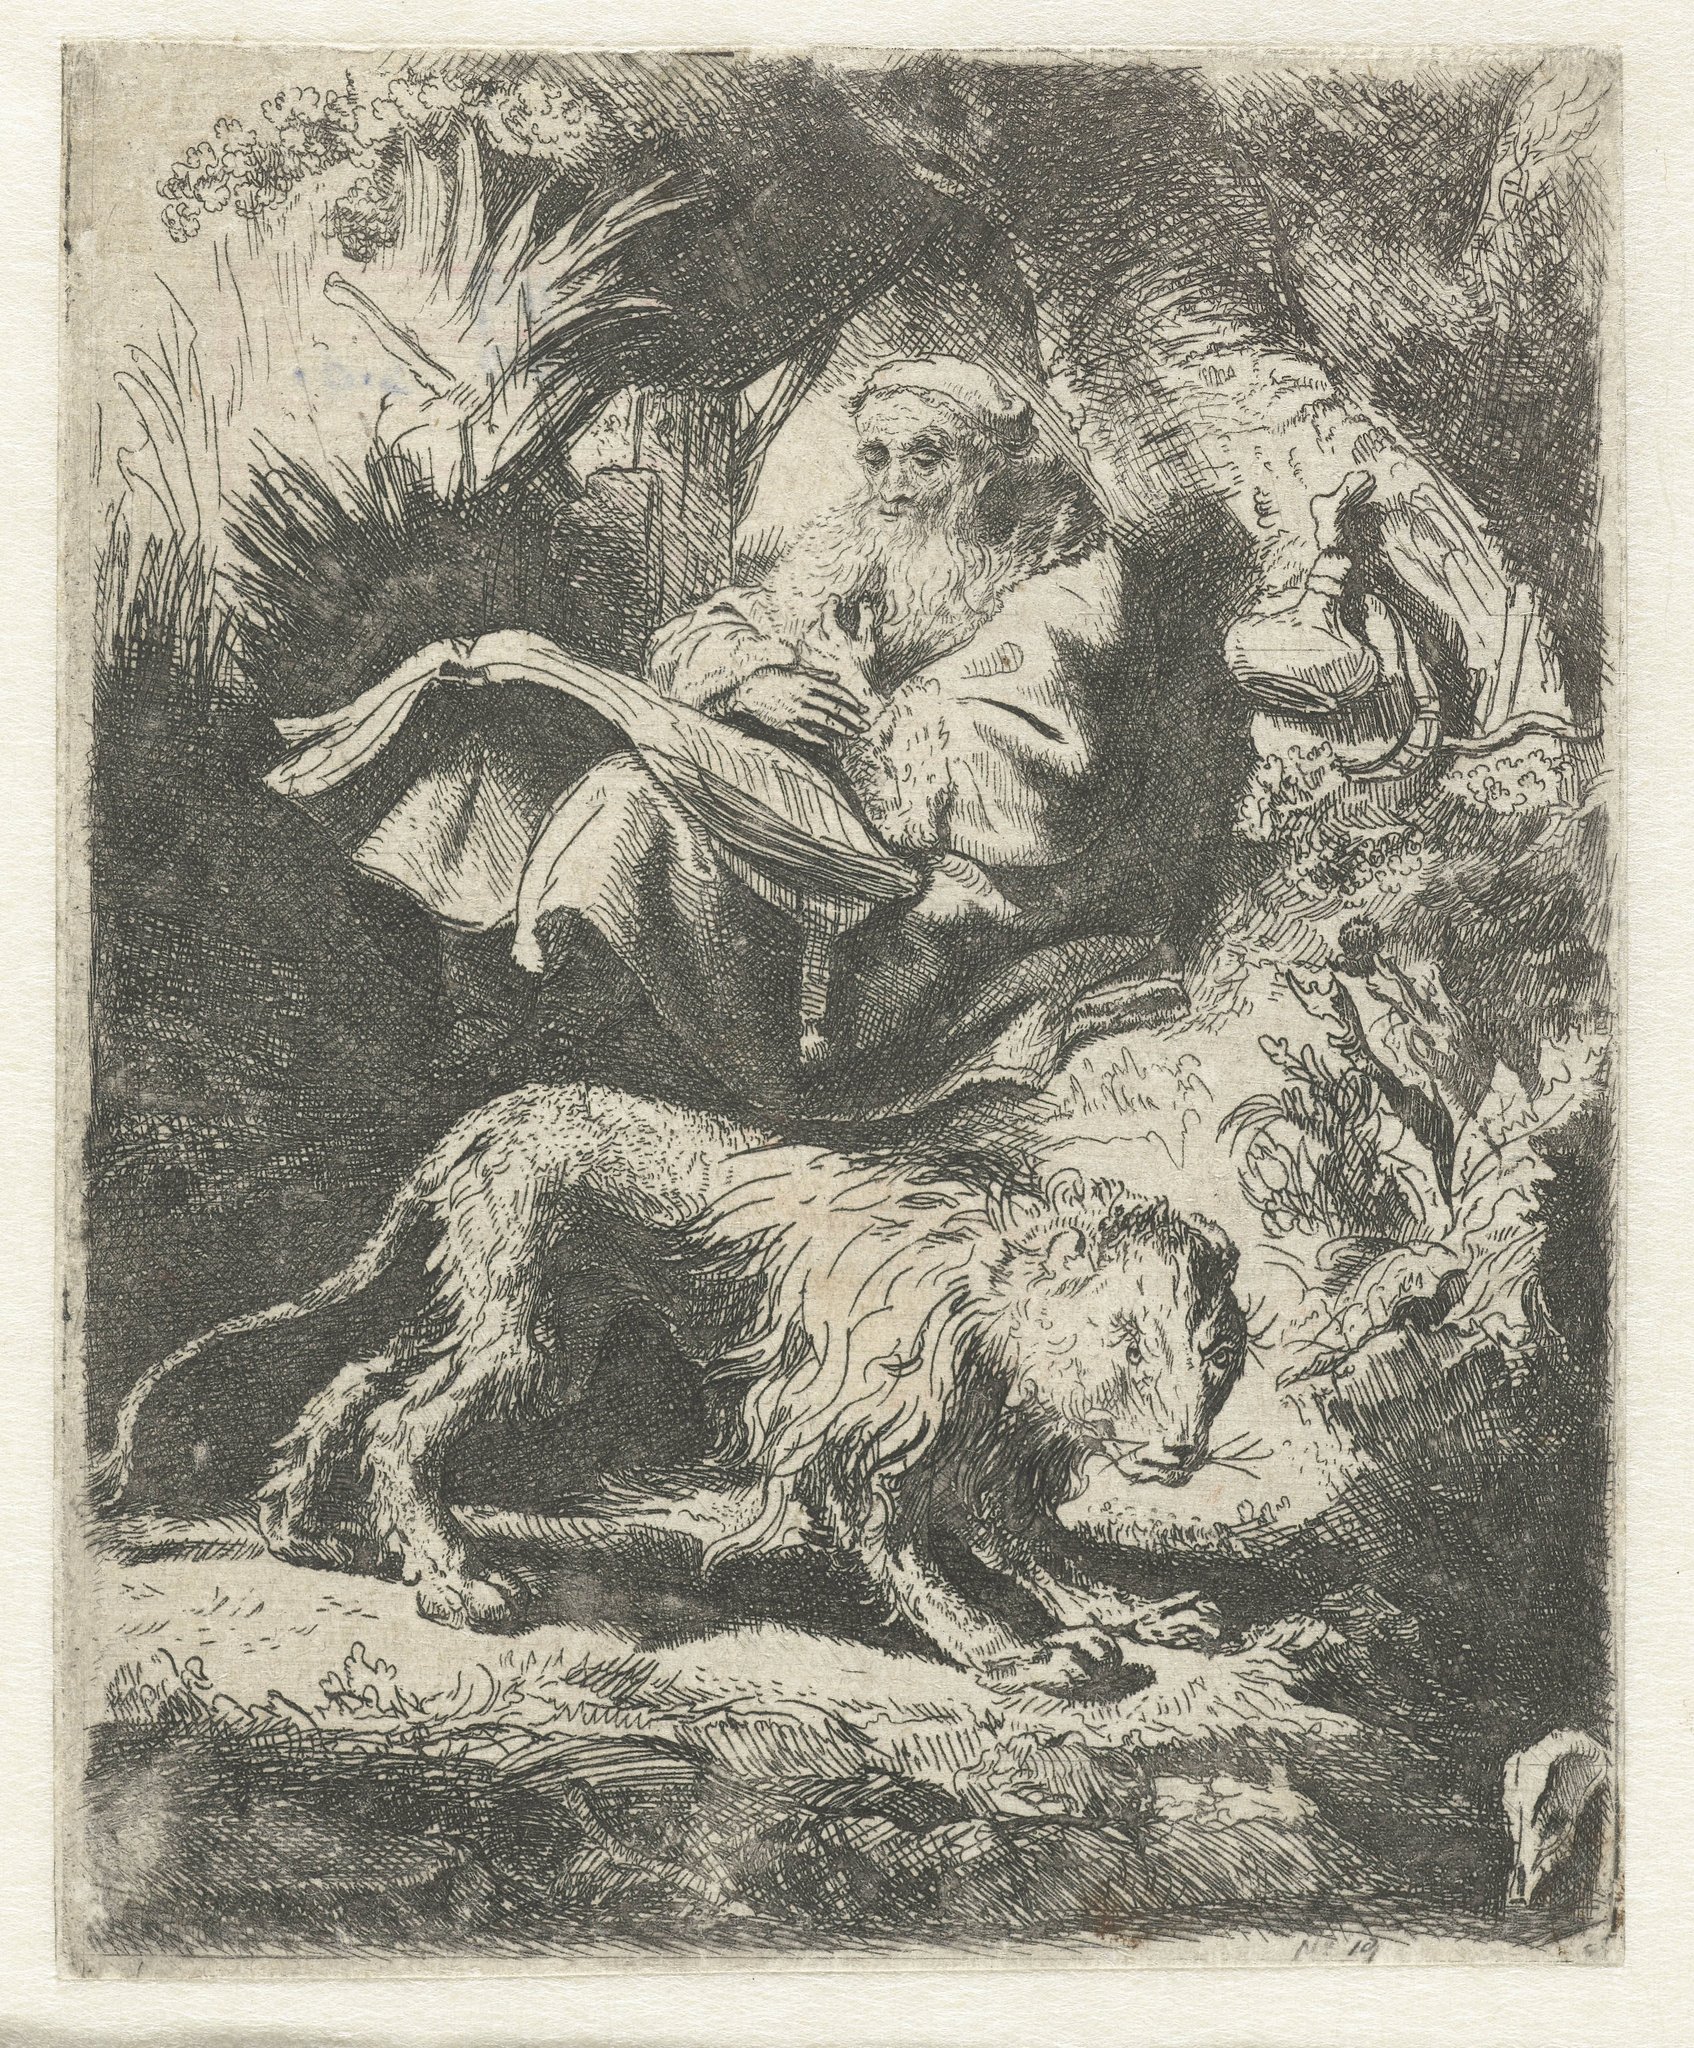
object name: print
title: St Jerome reading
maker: joseph-alexandre le campion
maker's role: print maker, publisher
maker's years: 1785-1802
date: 1795-1802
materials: paper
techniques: etching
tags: the monk and hermit jerome (hieronymus); possible attributes: book, cardinal's hat, crucifix, hour-glass, lion, skull, stone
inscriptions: collector's mark: Lugt 2228, number: ‘No 10’, collector's mark: Lugt 2760, stamp